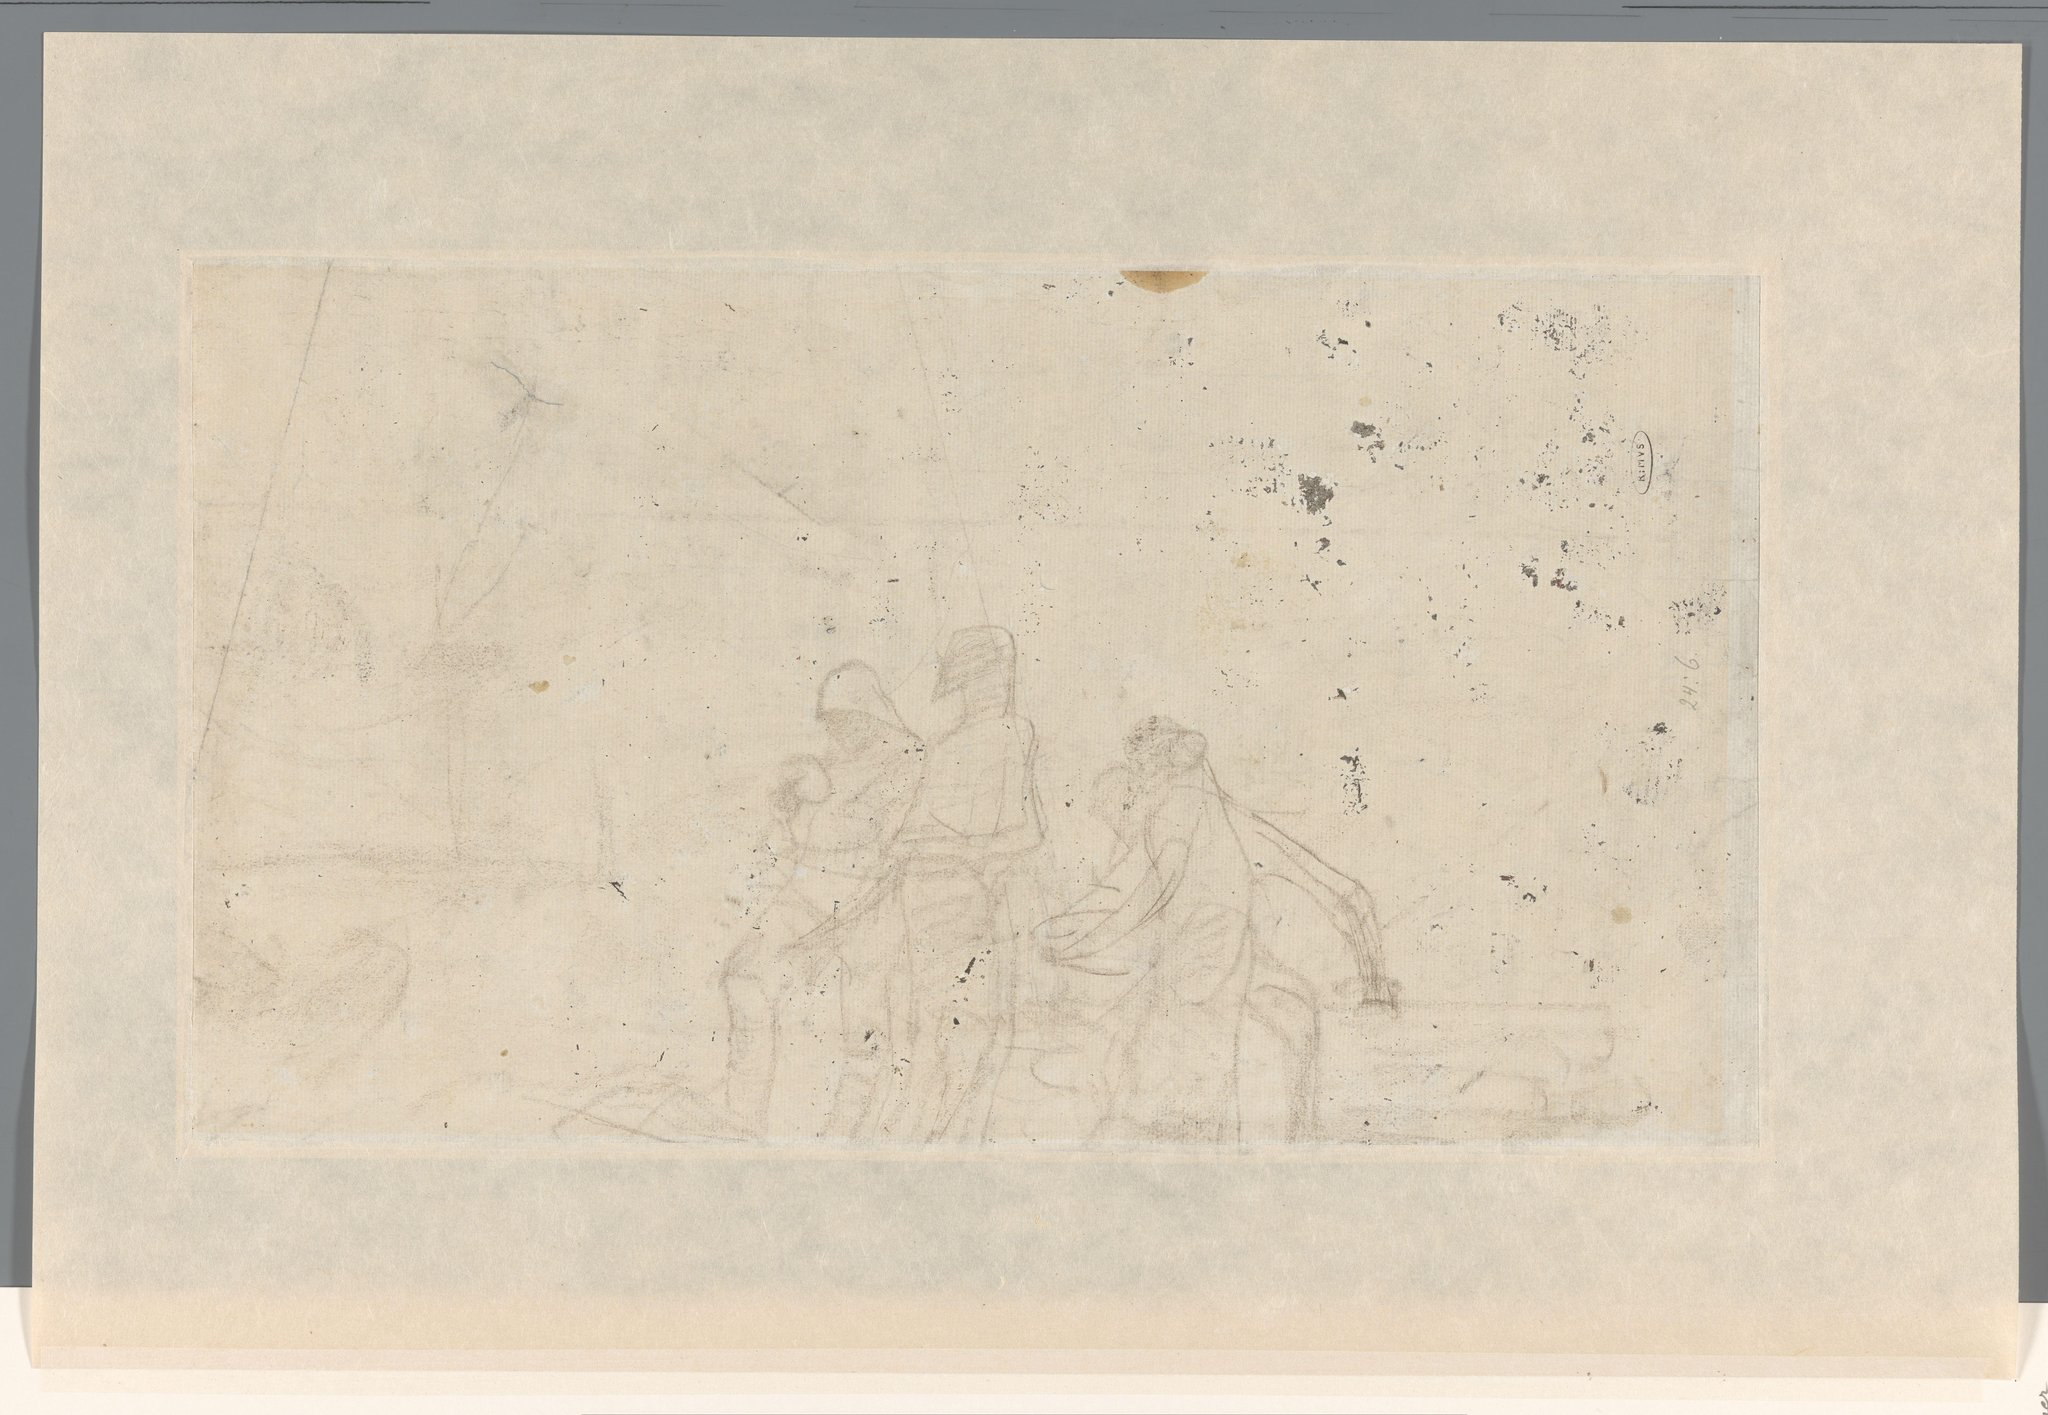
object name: drawing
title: Schets van een groep personen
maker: george hendrik breitner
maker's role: draughtsman, painter, print maker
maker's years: 1857-1923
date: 1867-1923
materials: charcoal, paper